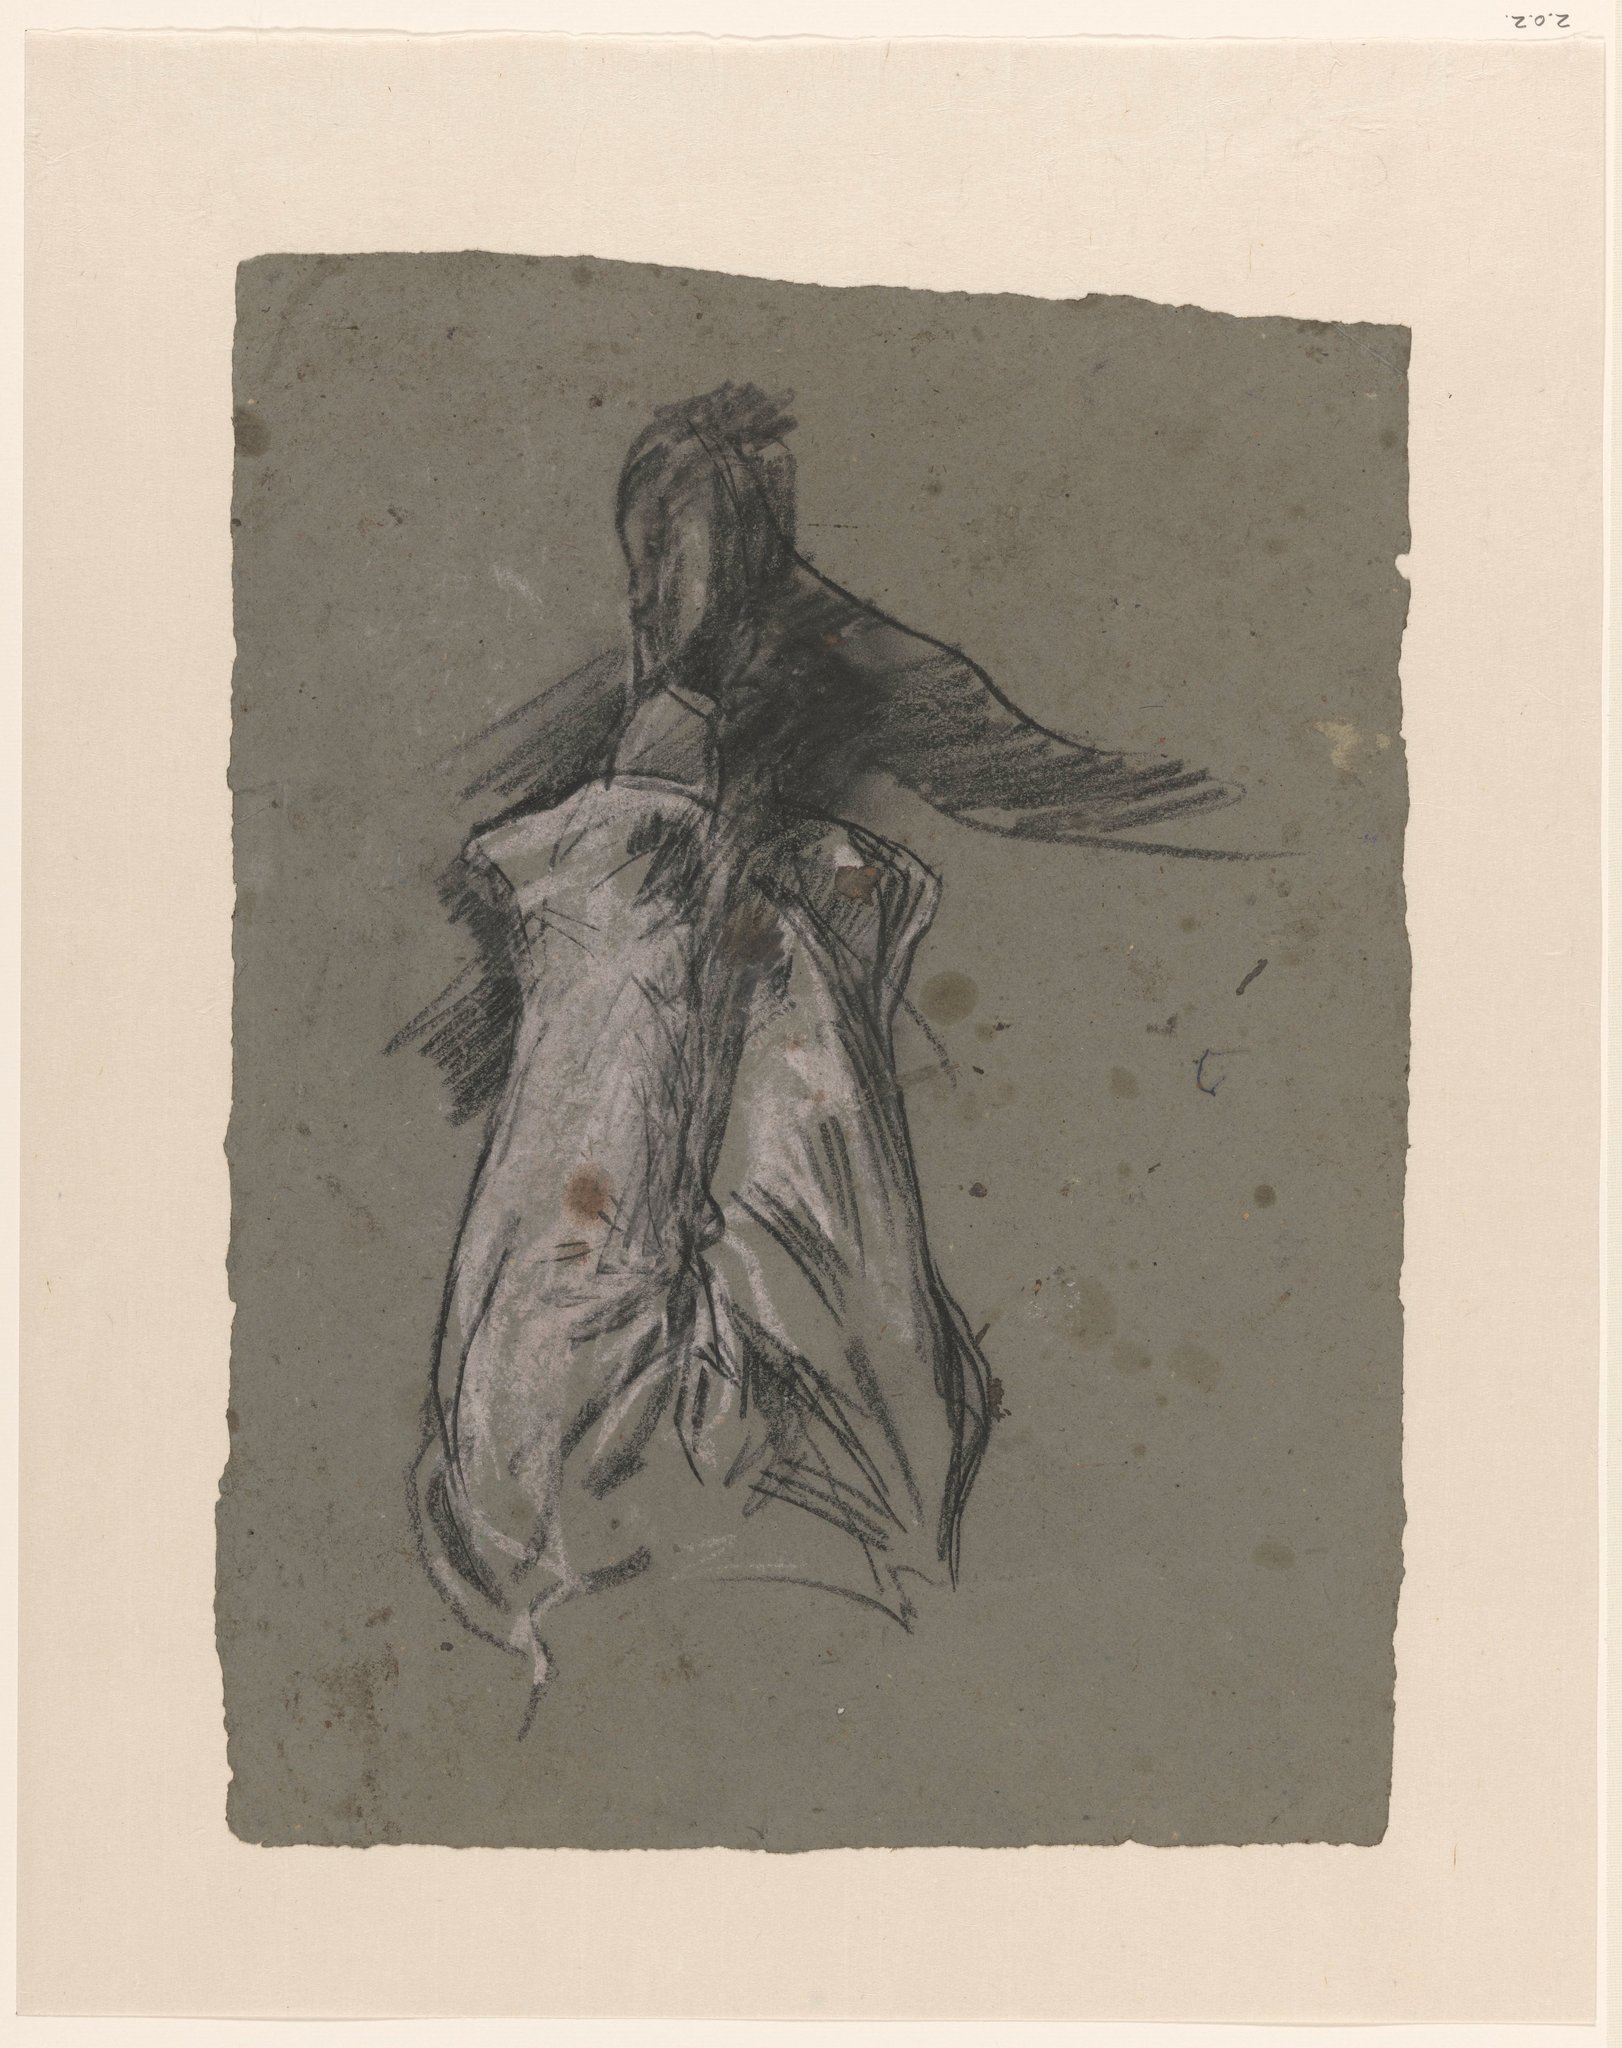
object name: drawing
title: Benen van voorovergebogen figuur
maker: jac van looij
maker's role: draughtsman, painter, print maker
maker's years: 1855-1930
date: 1865-1930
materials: chalk, paper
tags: legs